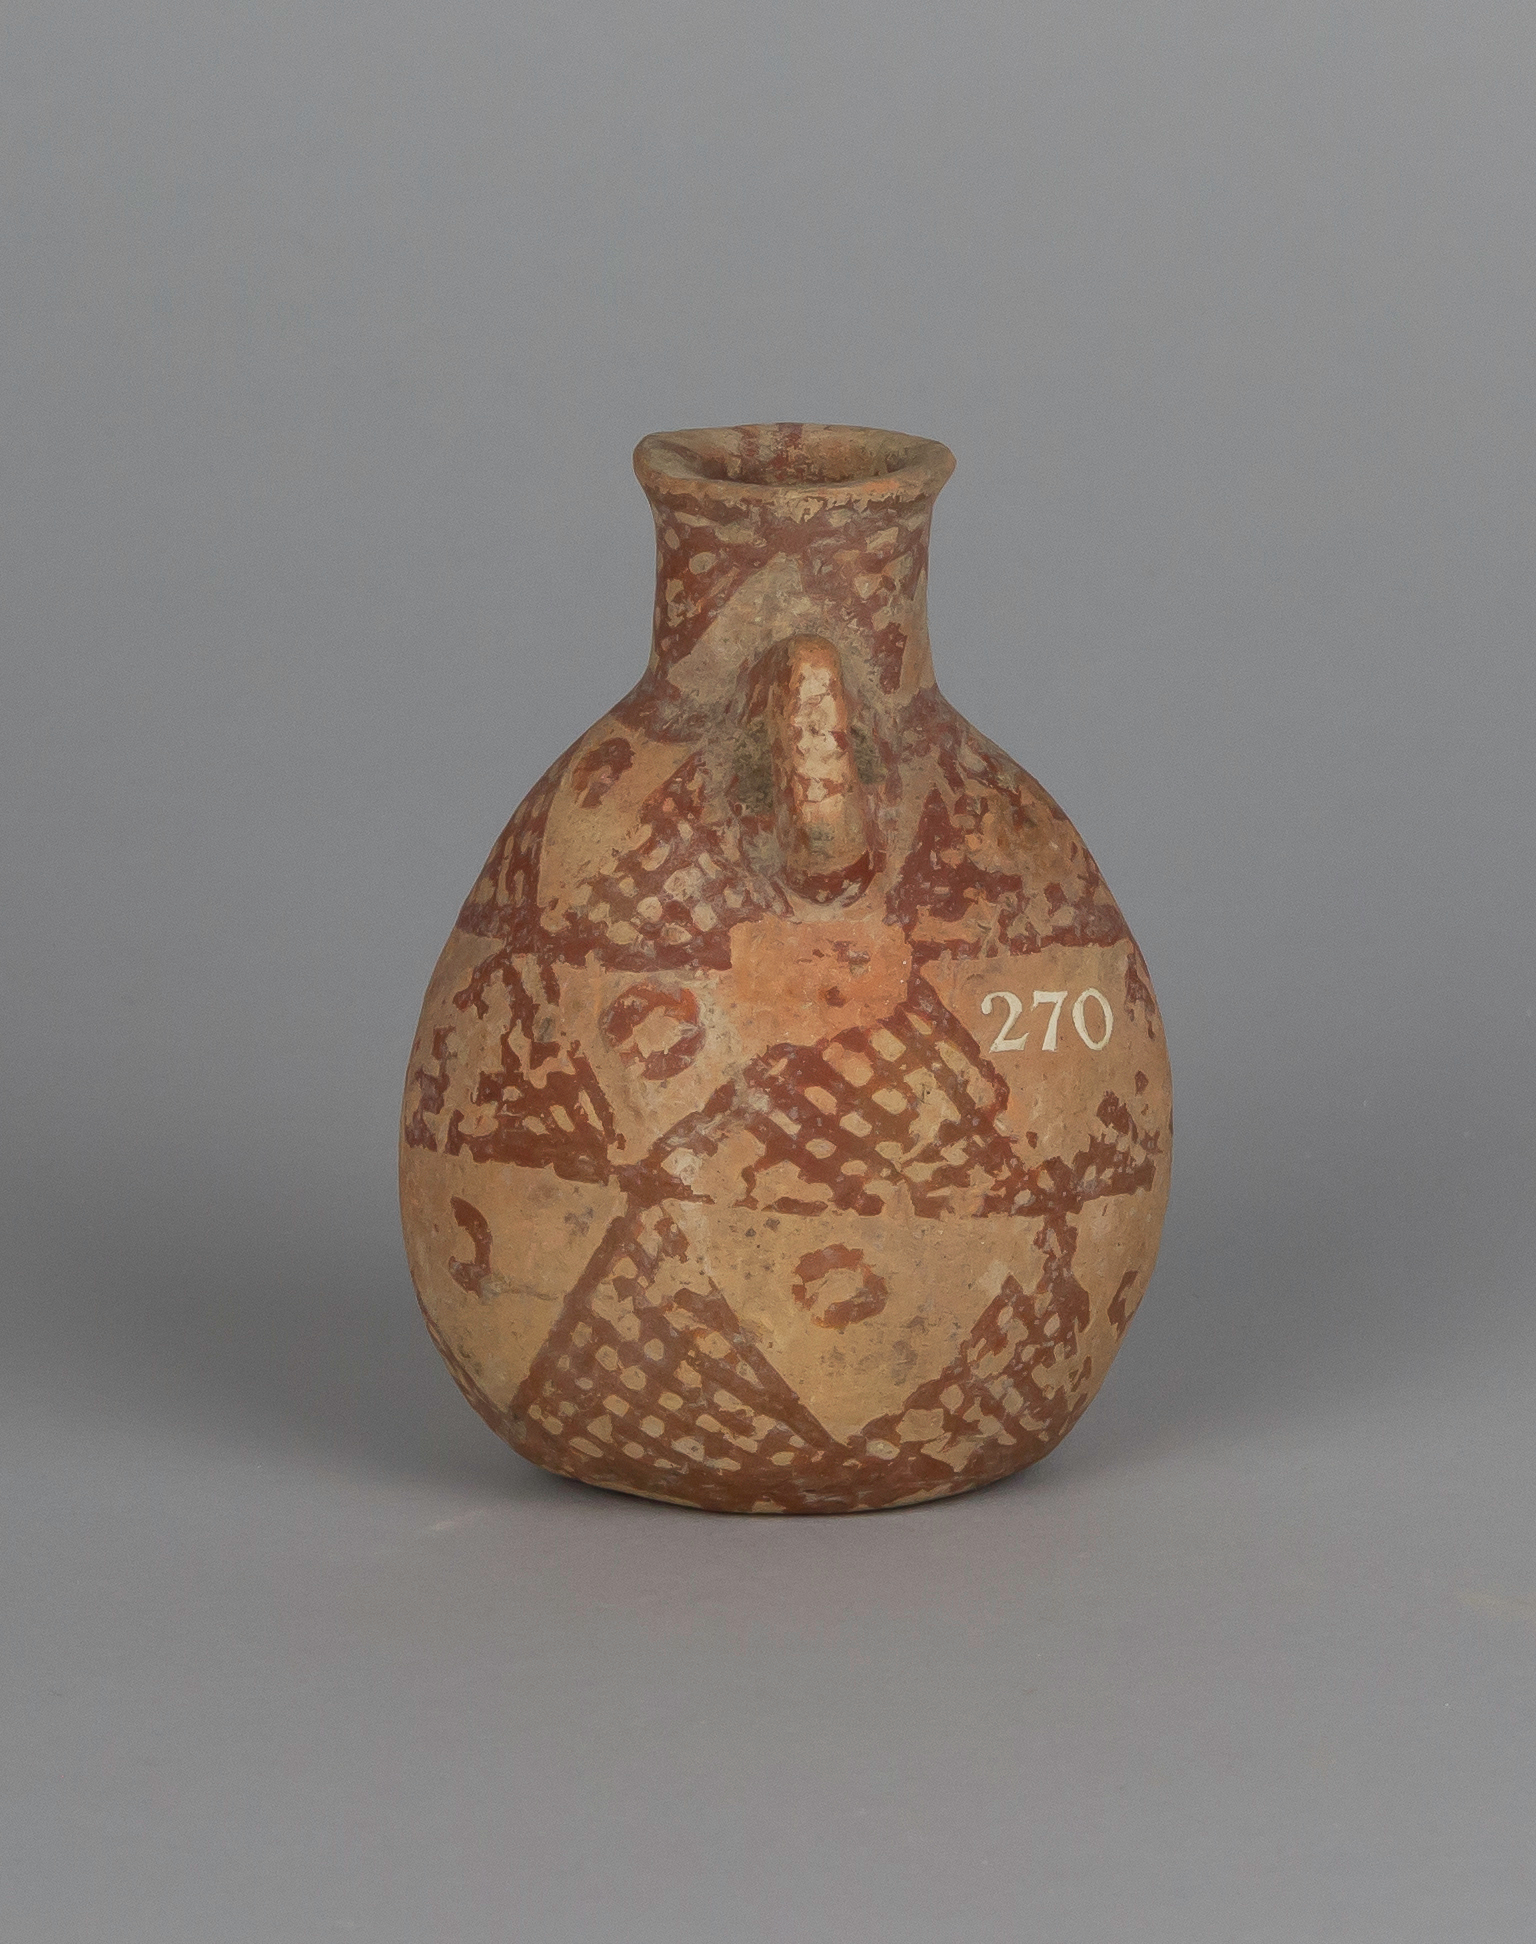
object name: flask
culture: cypriot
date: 3200-1050 BCE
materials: terracotta